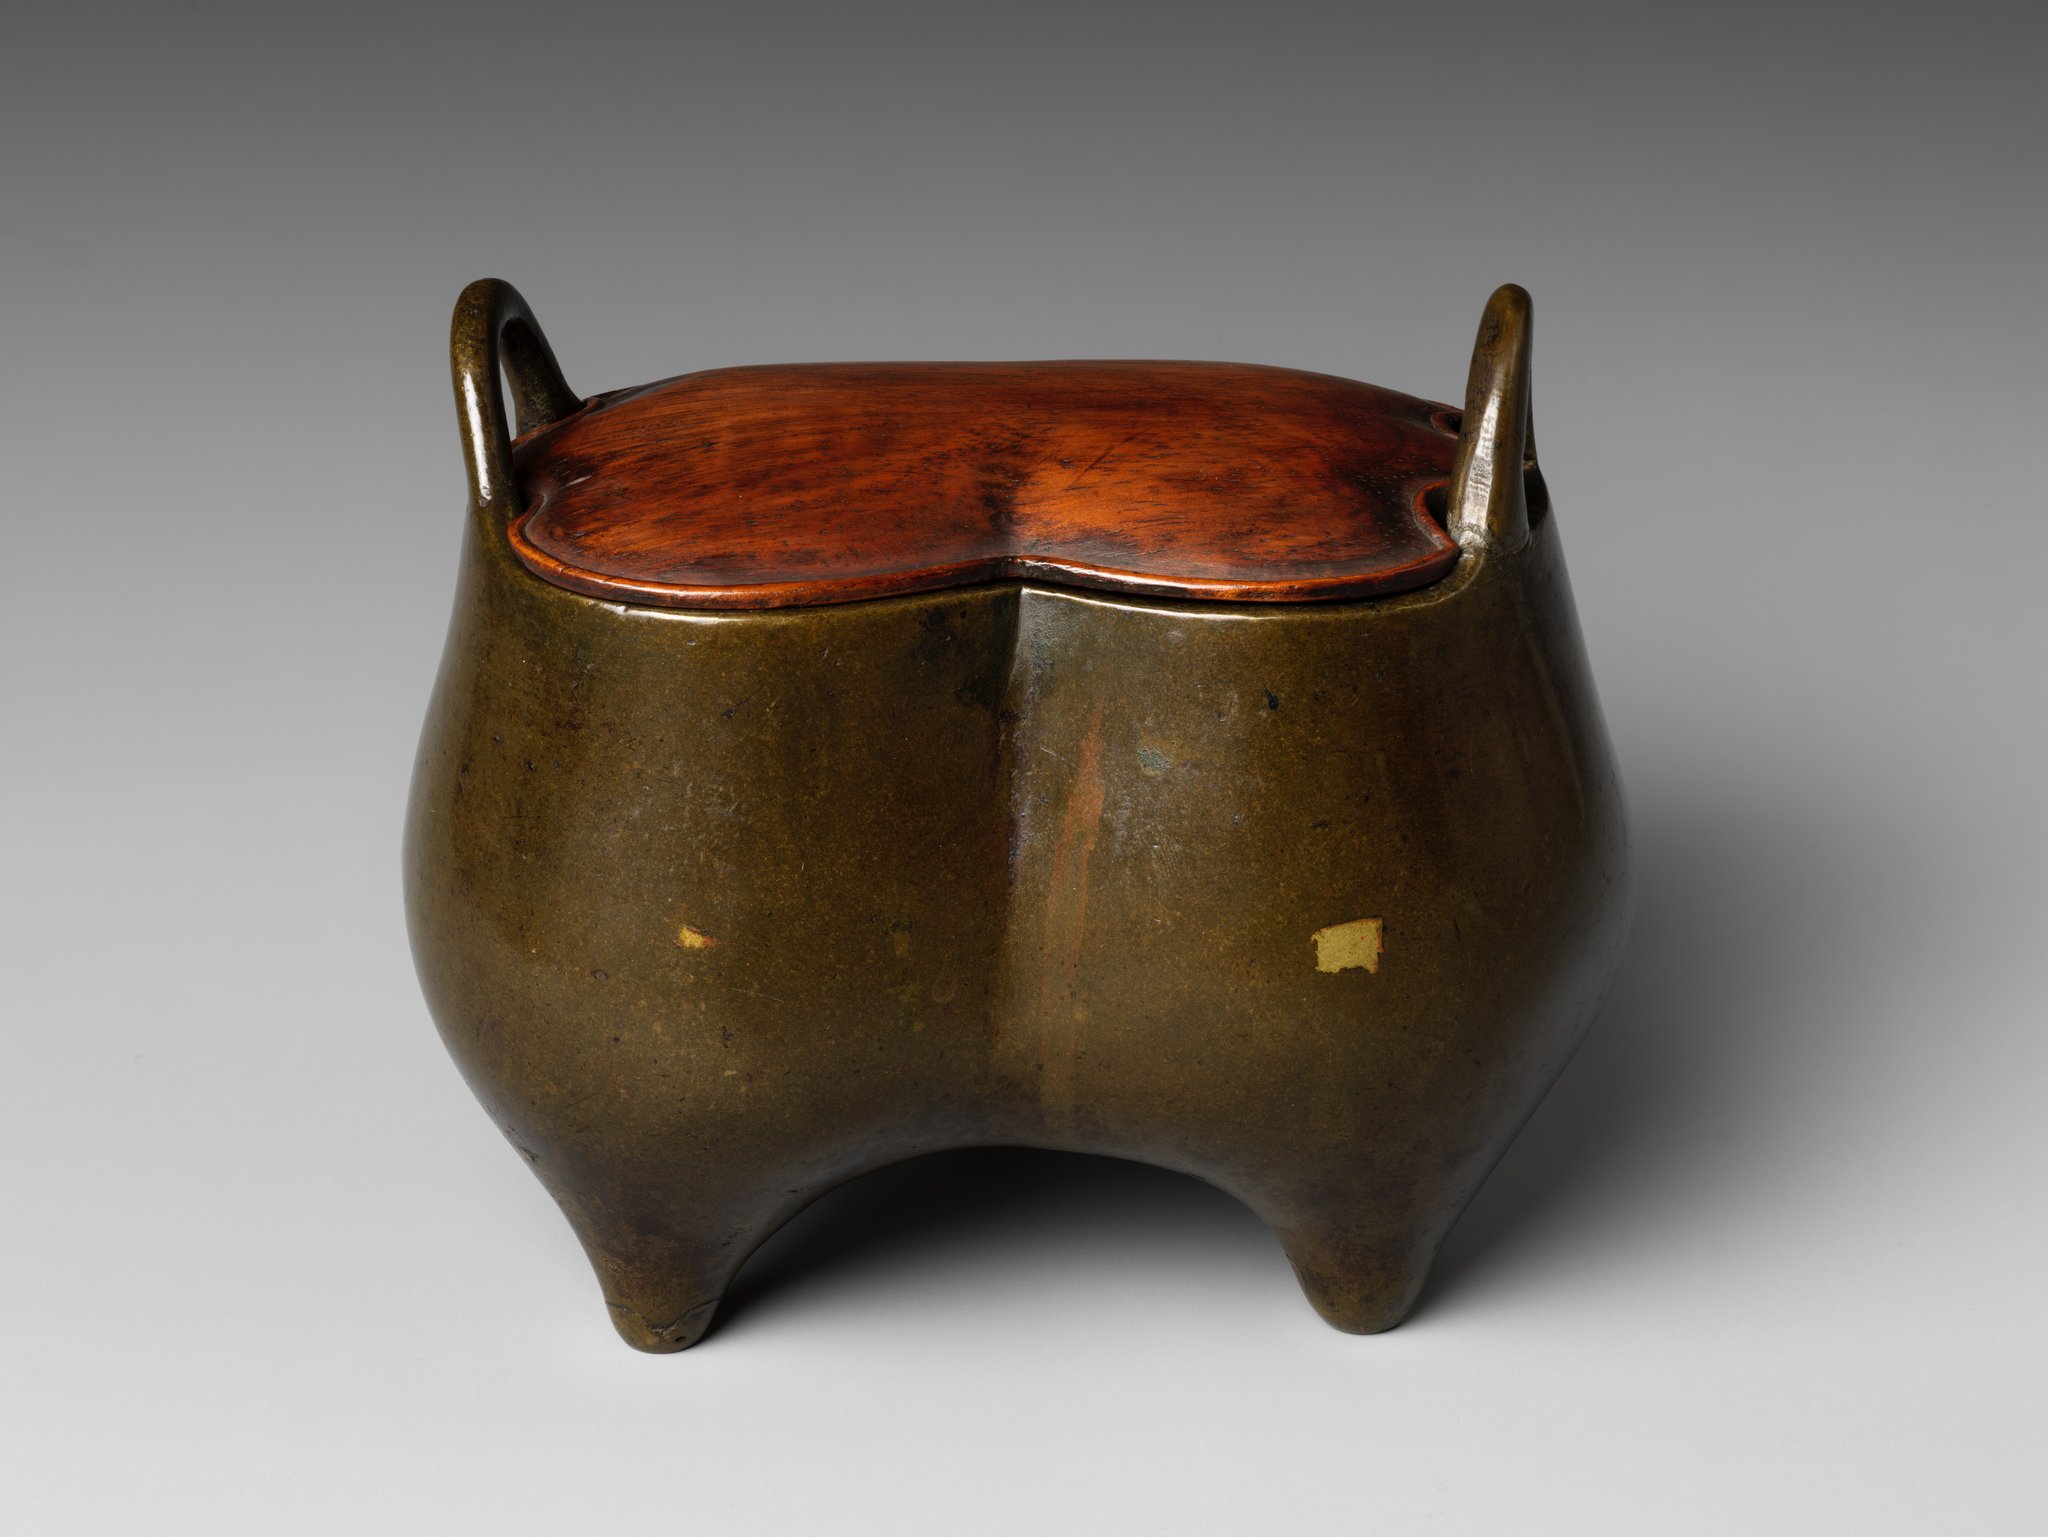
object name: incense burner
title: Tripod incense burner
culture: chinese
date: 1601-1700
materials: copper alloy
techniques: gilding